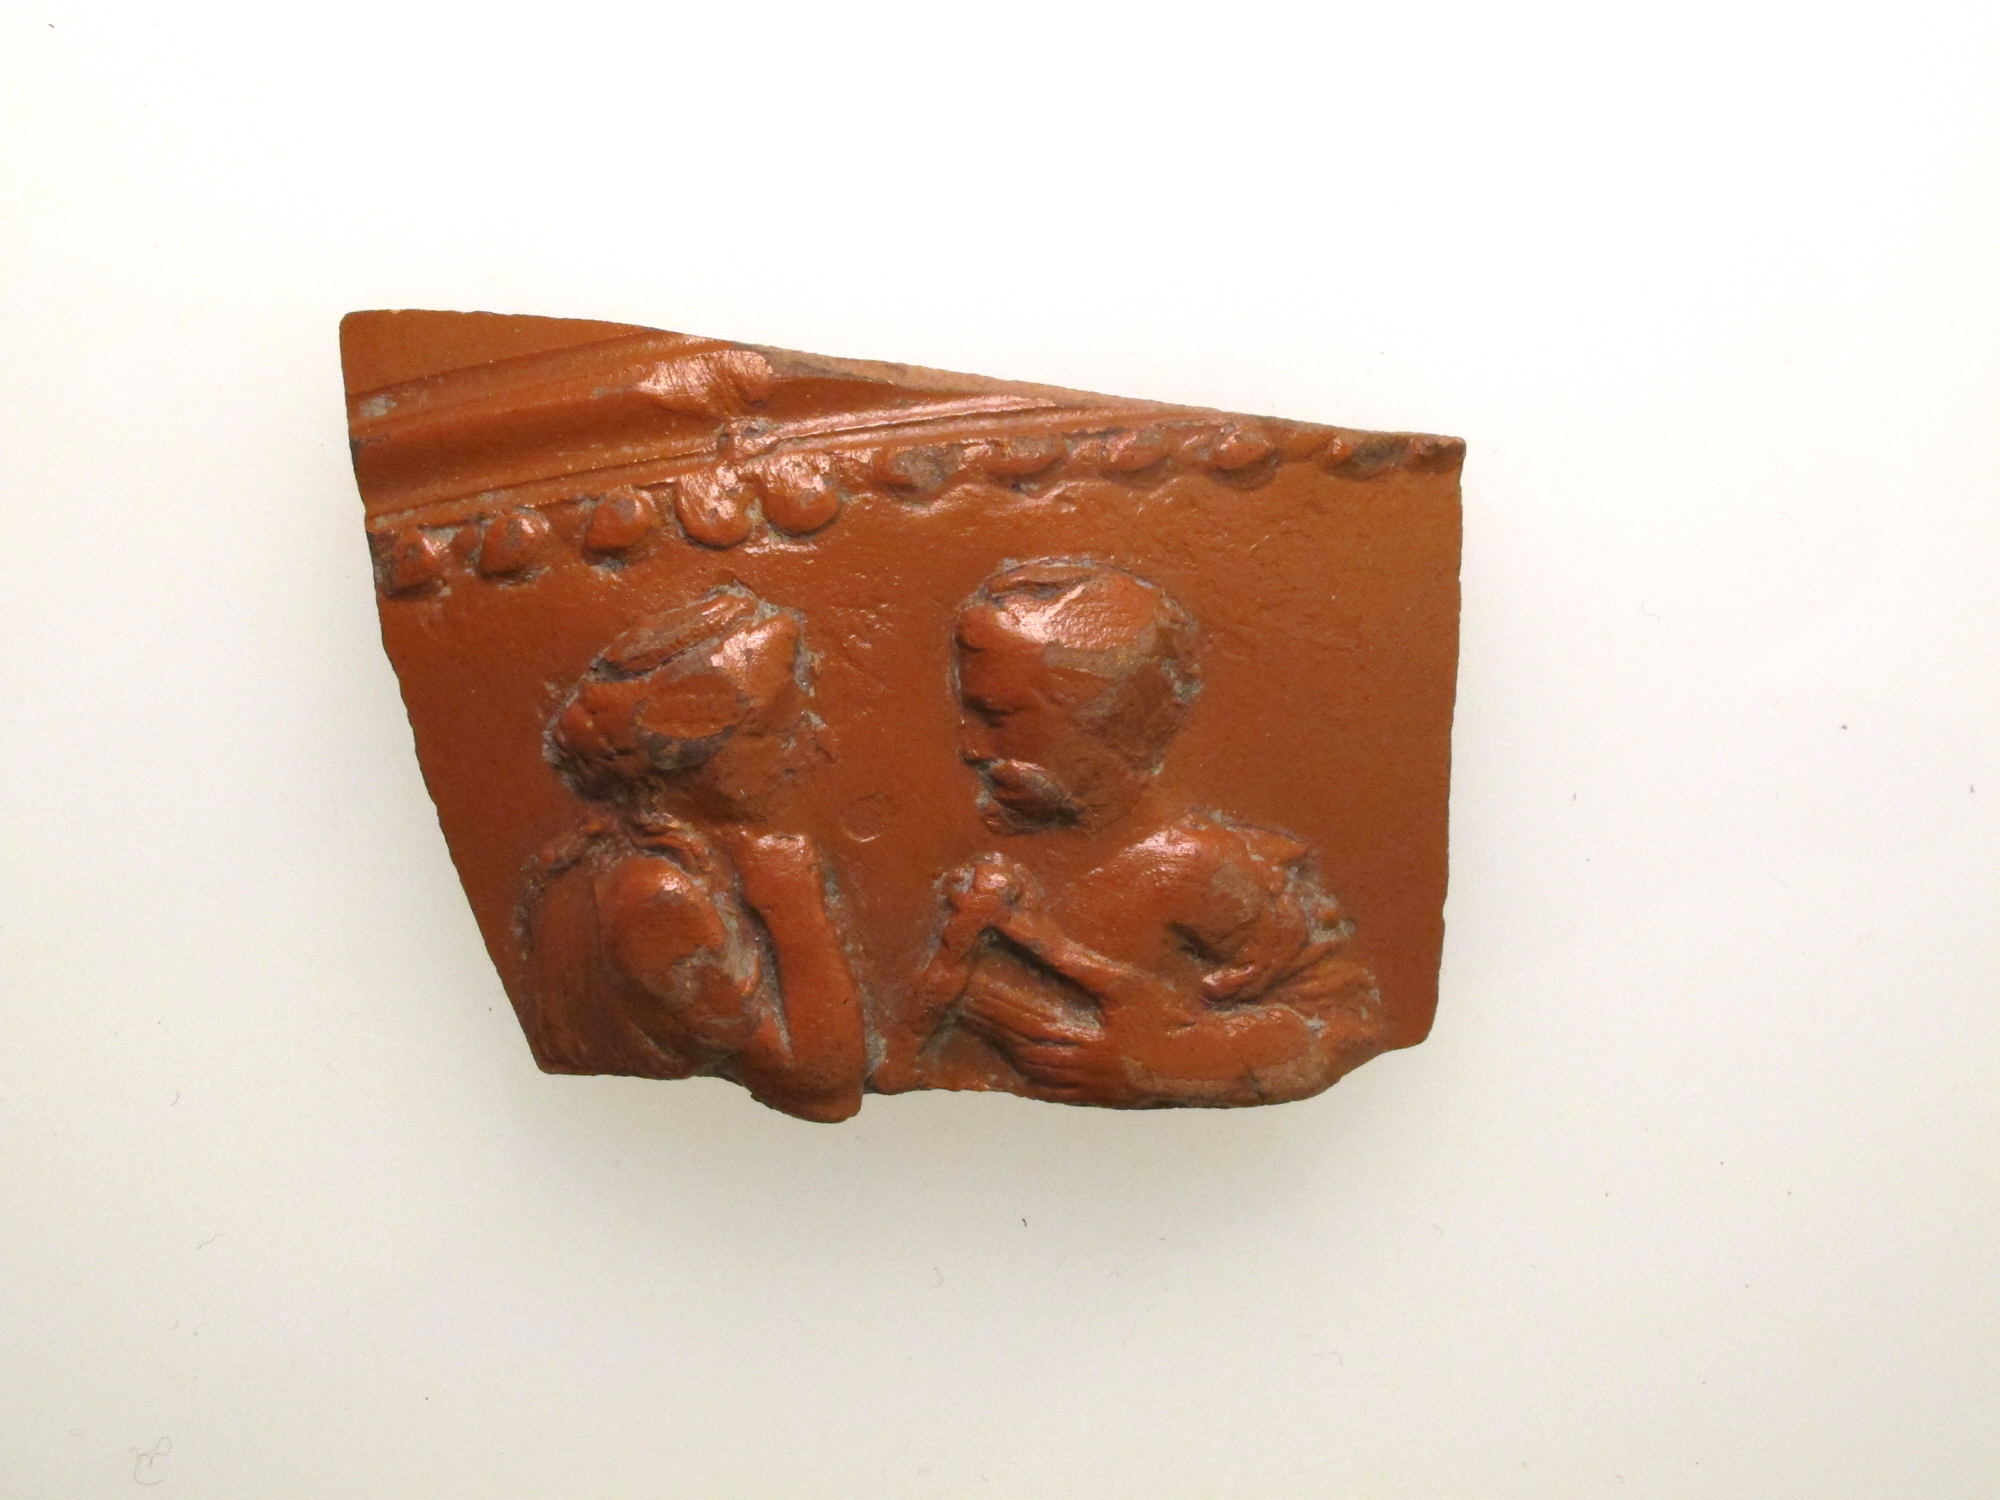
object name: vase fragment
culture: roman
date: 100 BCE-100 CE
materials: terracotta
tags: men,women